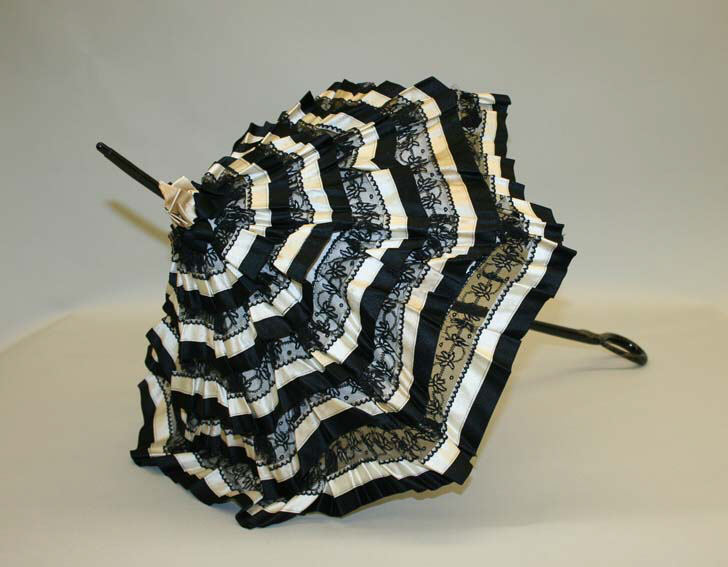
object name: parasol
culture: american or european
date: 1867-1900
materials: cotton, metal, silk, wood